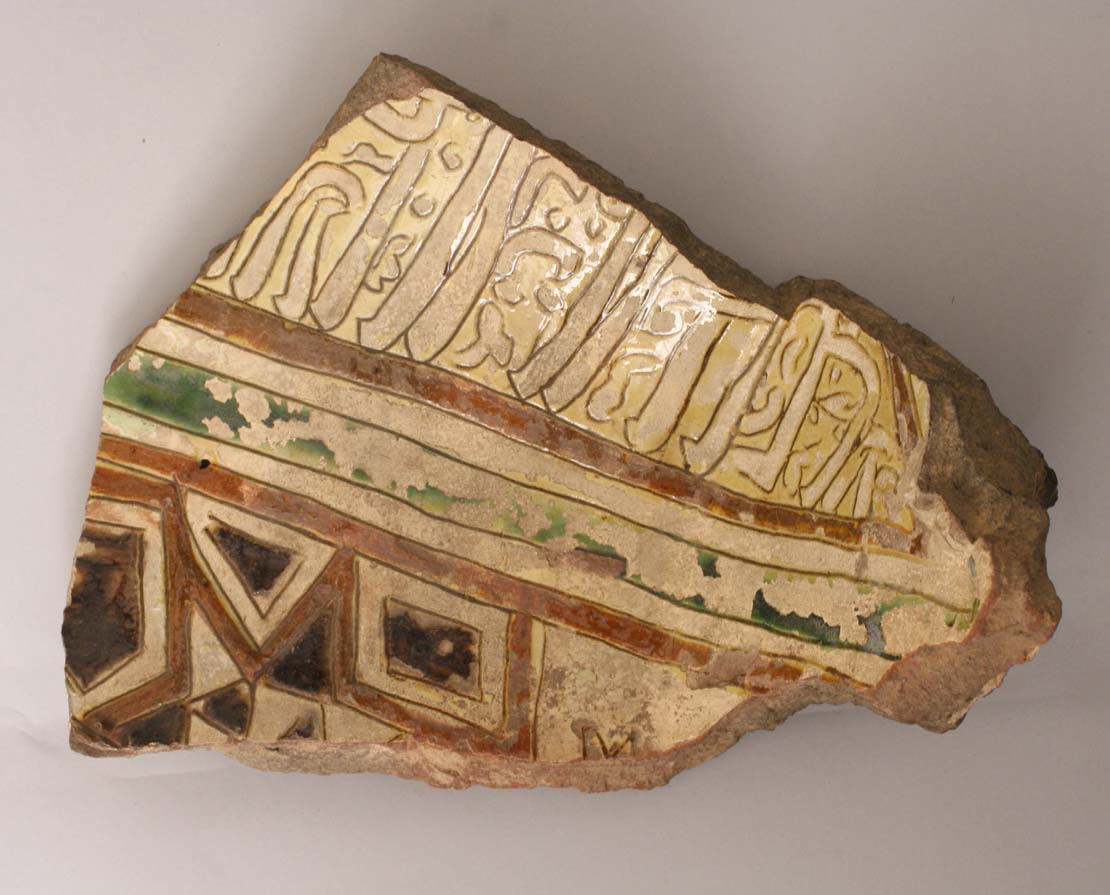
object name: fragment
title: Ceramic Fragment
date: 1301-1500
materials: earthenware, glaze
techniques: coloring, incising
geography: egypt